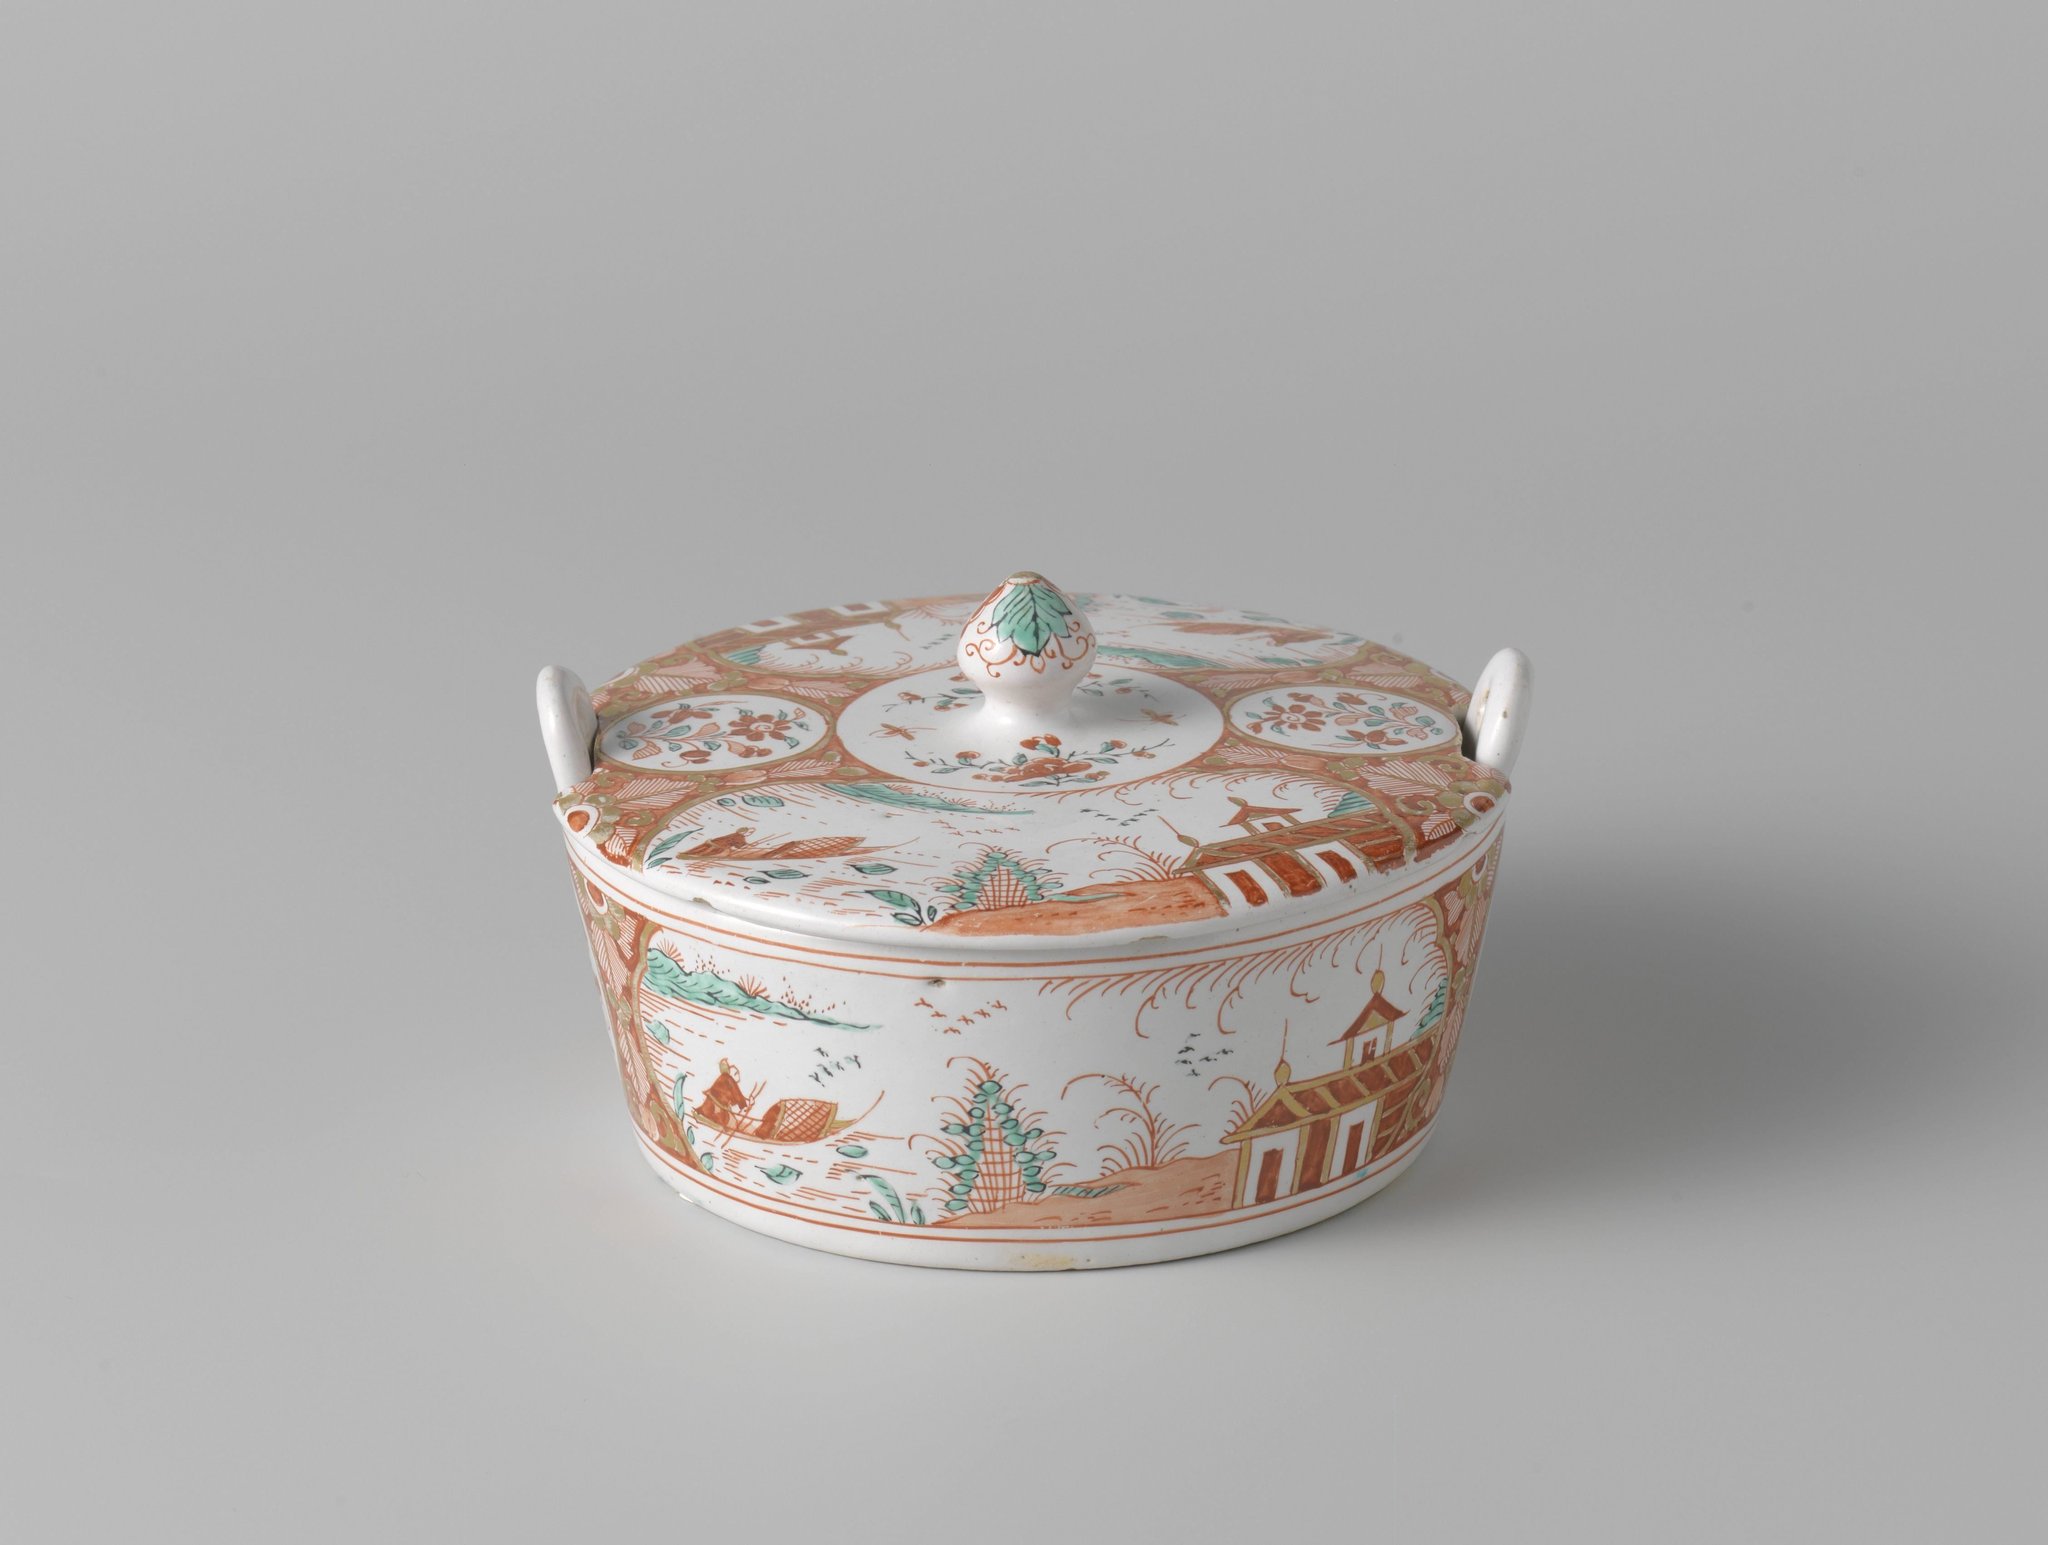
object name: lid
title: Deksel van botervloot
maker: Anonymous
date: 1740-1765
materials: faience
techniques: kiln, painted, polychromy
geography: delft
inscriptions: inscription: ‘5?’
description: Deksel van botervloot met opstaande oortjes veelkleurig beschilderd met een oosters landschap met gebouwen binnen cartouches.